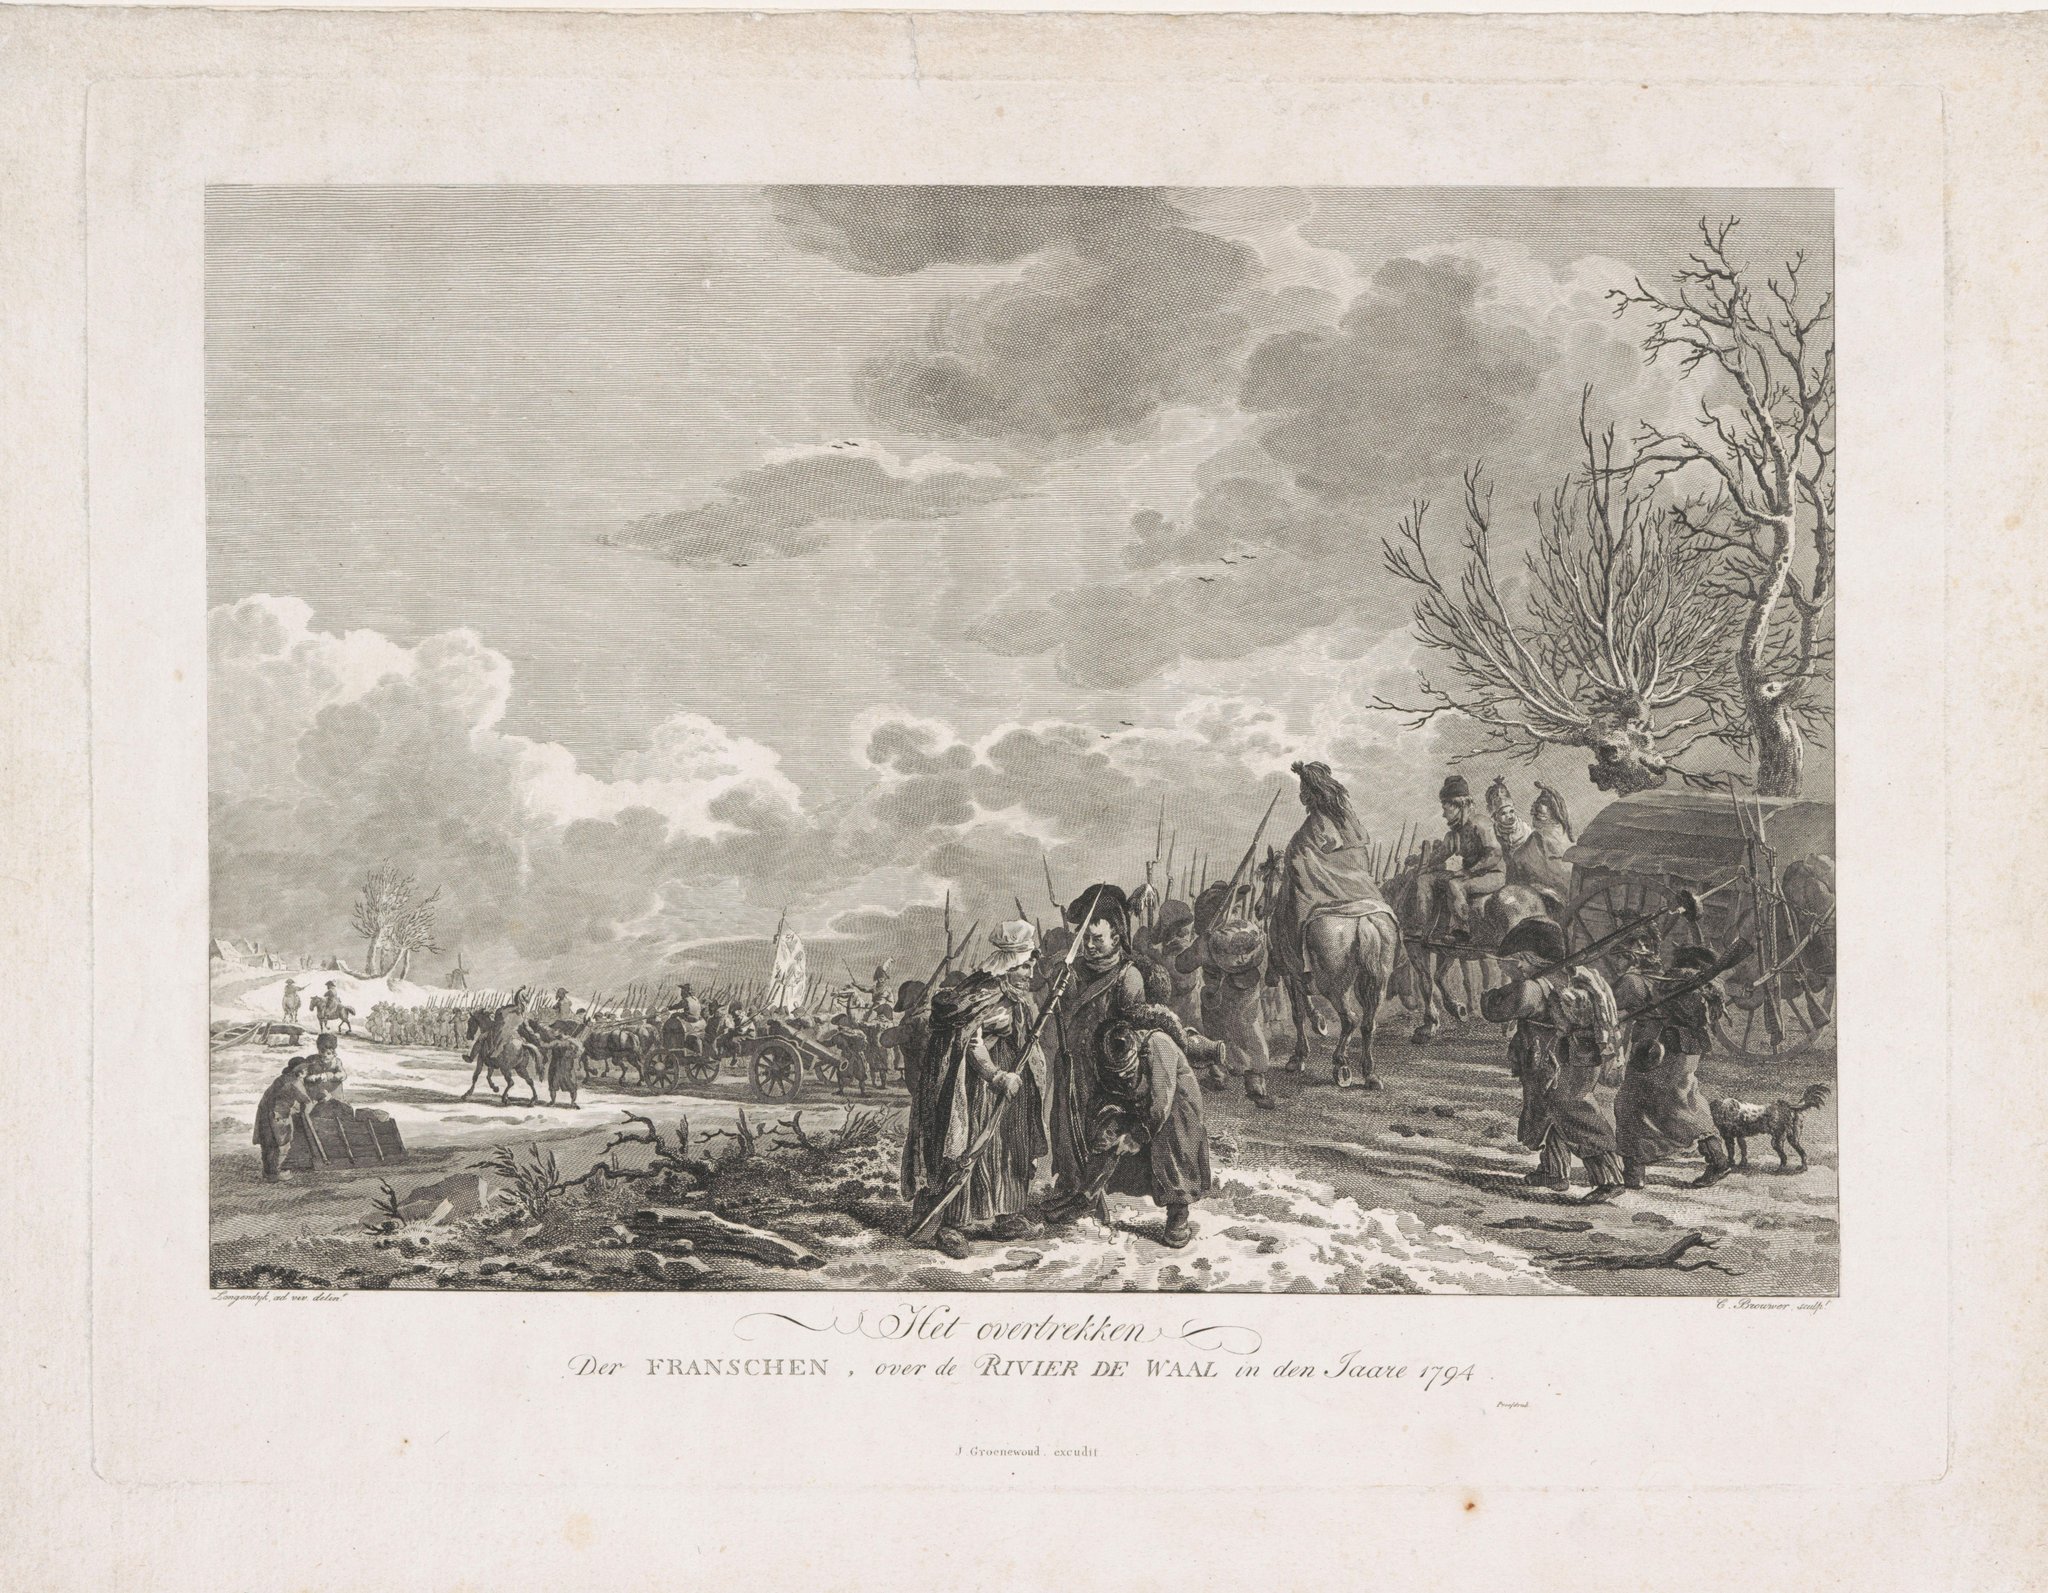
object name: print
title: Pichegru steekt de bevroren Waal over, 1794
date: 1795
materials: paper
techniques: engraving, etching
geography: northern netherlands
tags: paris, politician, jean-charles pichegru, march into the conquered place, transport, train (military) (+ land forces)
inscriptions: collector's mark: Lugt 2228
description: De Franse troepen onder generaal Pichegru steken de bevroren Waal over, 28 januari 1794.